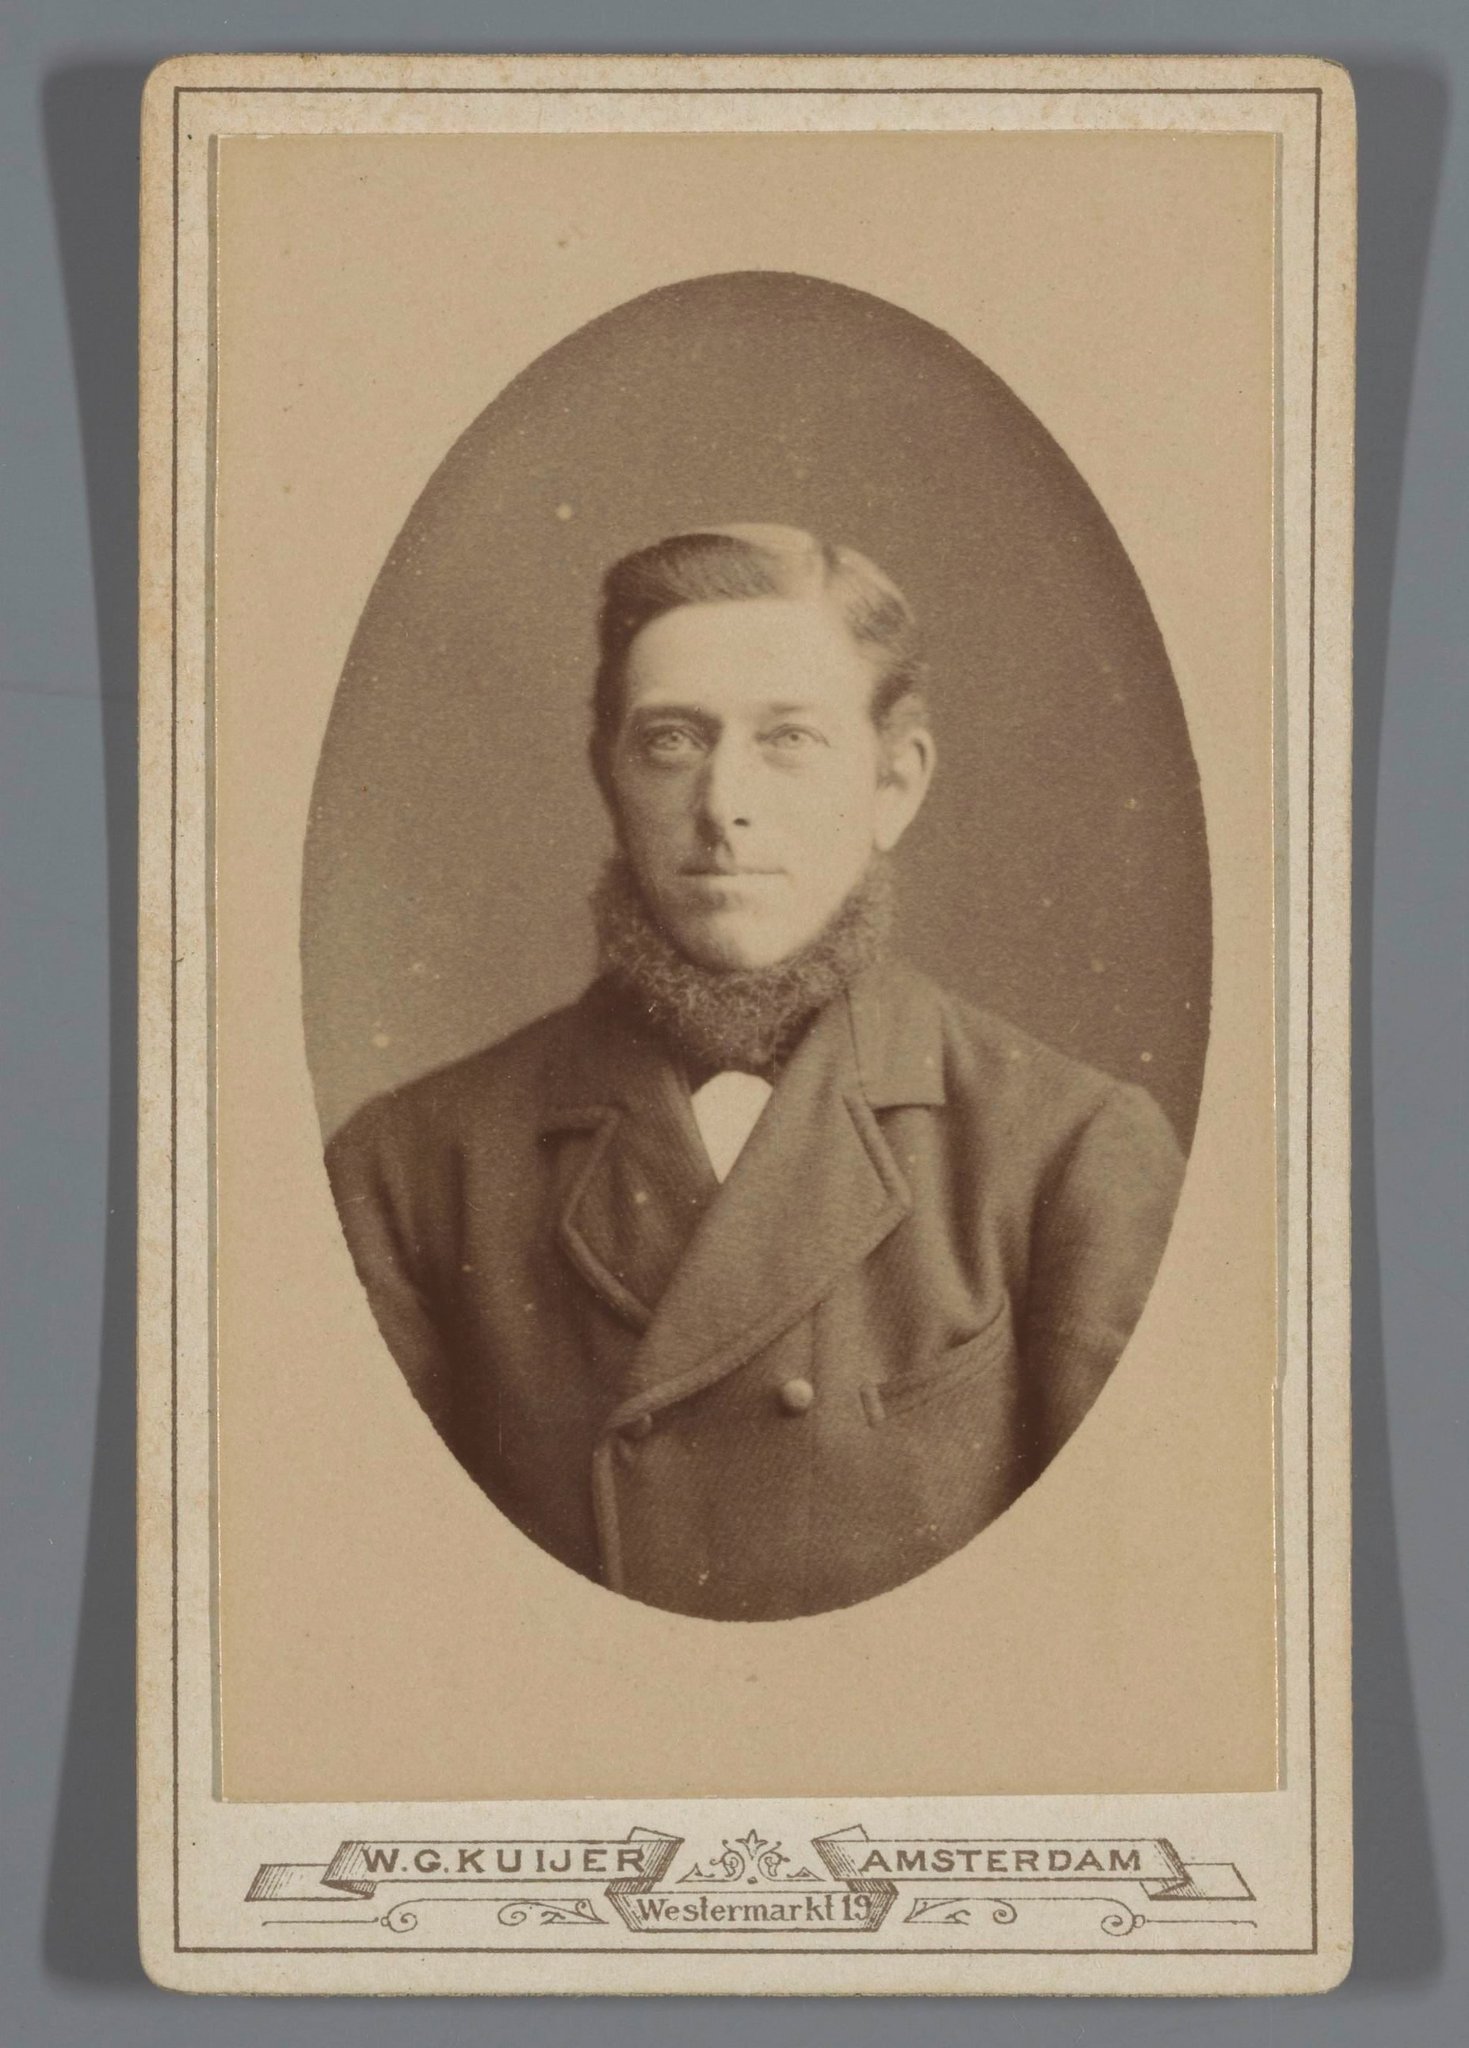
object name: semi enamel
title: Portret van Jan Reijnders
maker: willem gerhardus kuijer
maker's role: fotograaf, hoffotograaf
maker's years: 1834-1899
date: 1880-1906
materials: cardboard, celluloid, paper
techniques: albumen print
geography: amsterdam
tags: adult man, historical persons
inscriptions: number: ‘5’, inscription: ‘Photographie instantanée,/ W. G. Kuijer/ Westermarkt/ 19/ AMSTERDAM./ Speciale inrichting voor vergrootingen/ in alle formaten/ 4’, inscription: ‘Jan Reijnders’